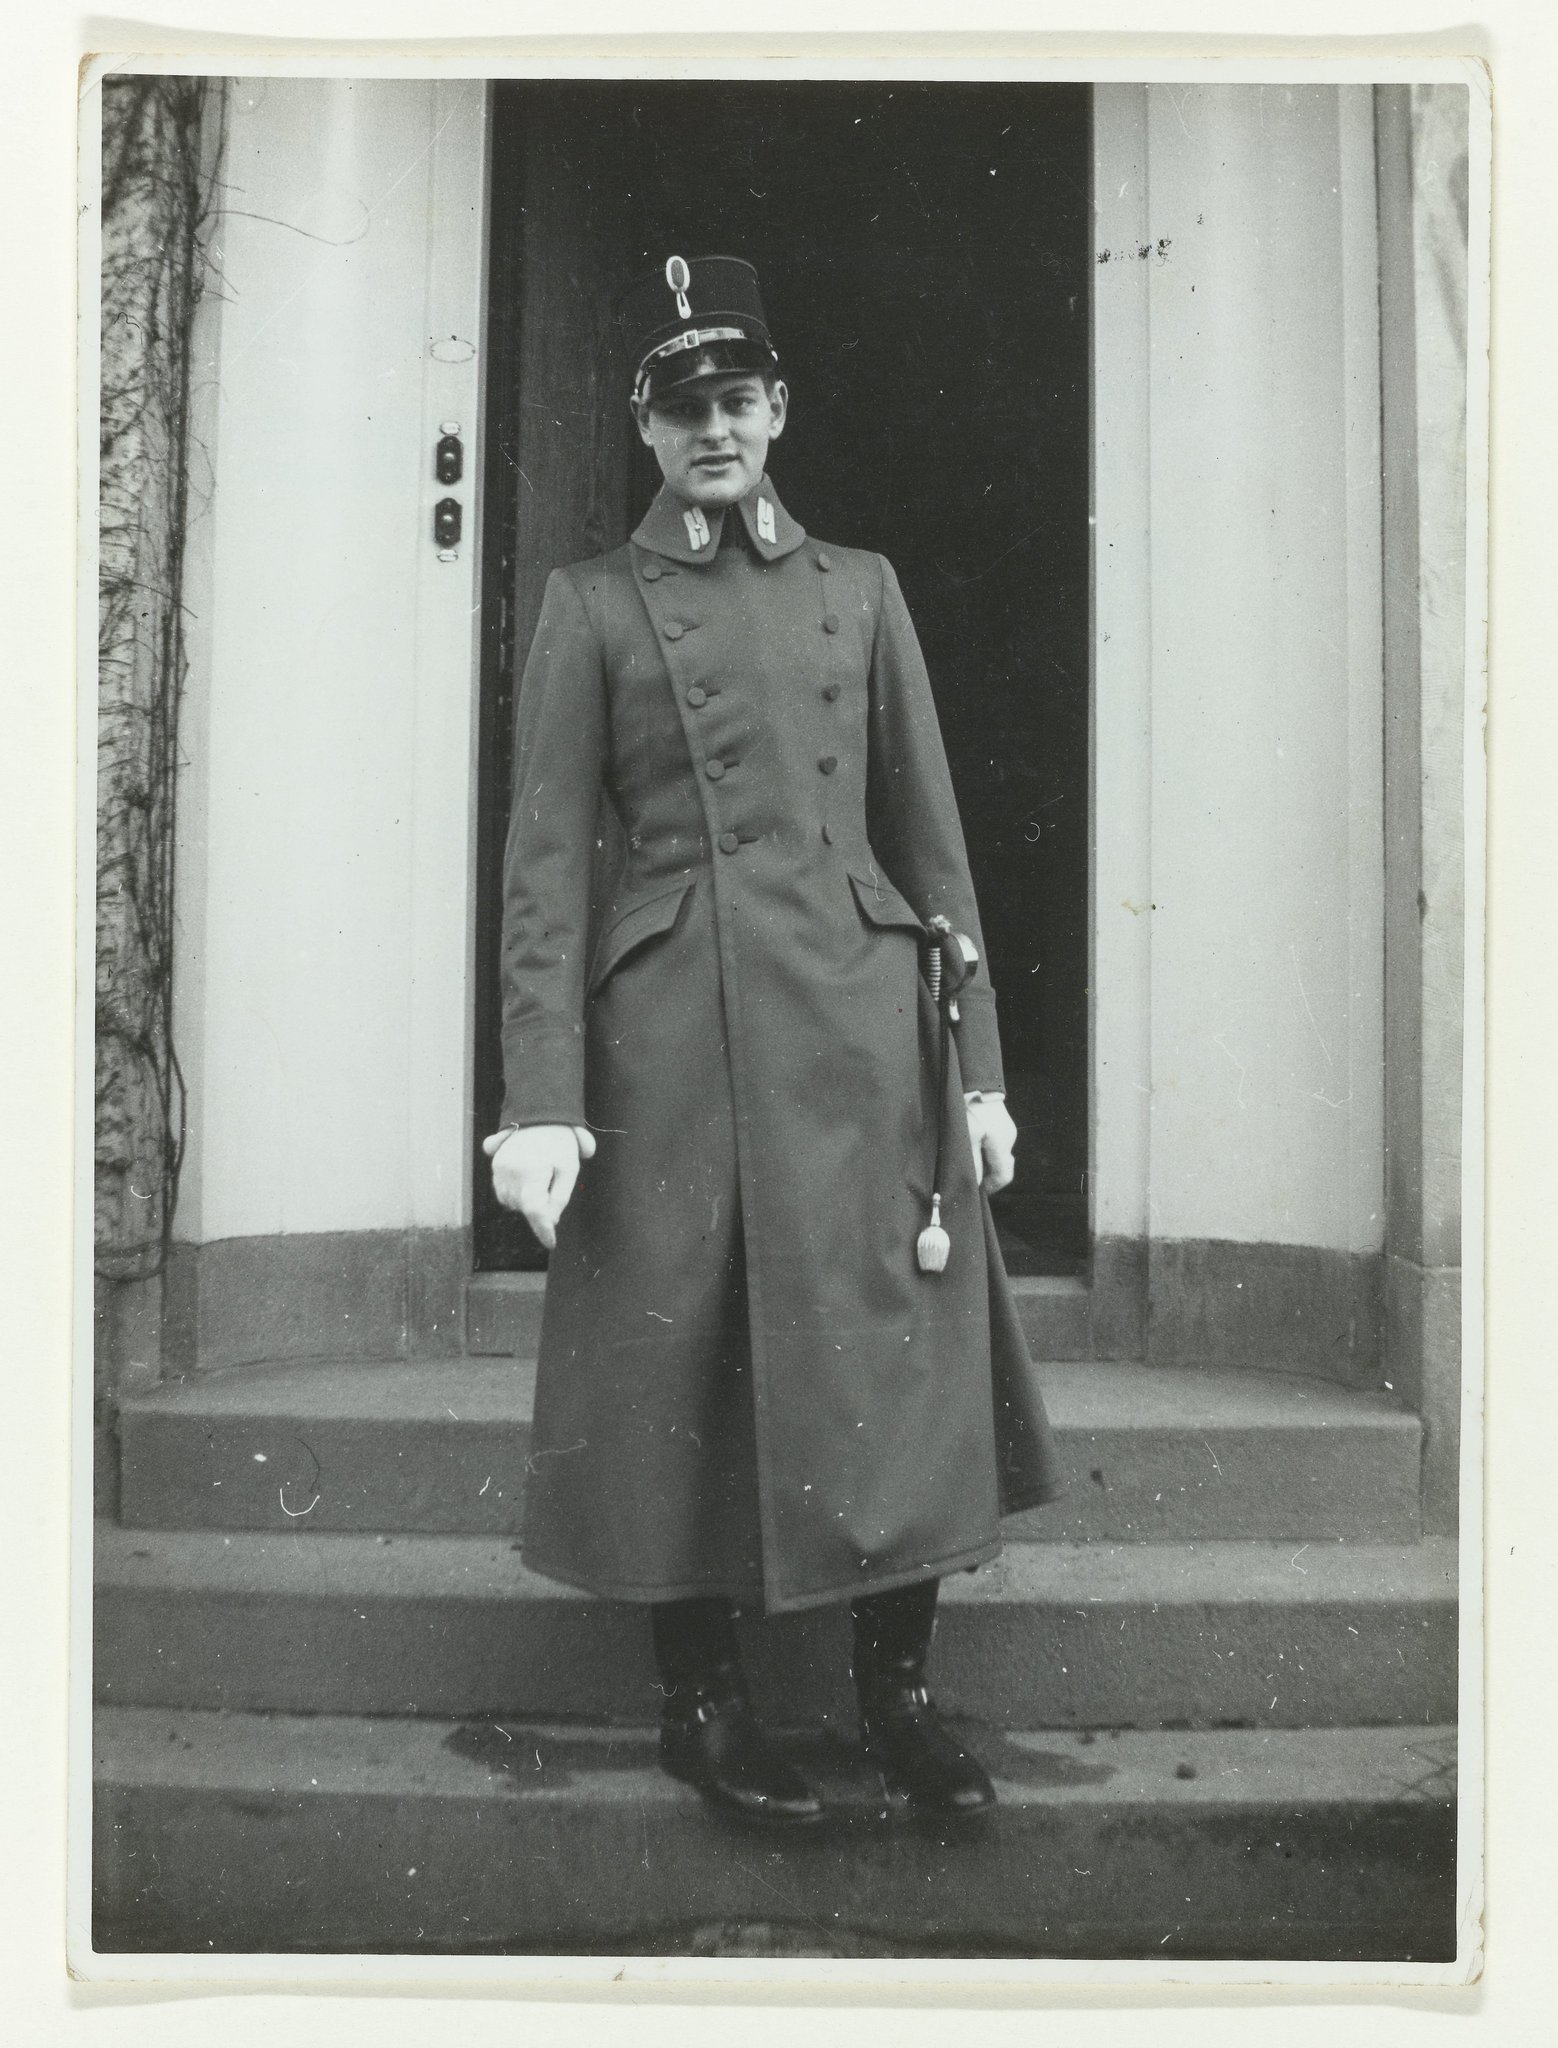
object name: photograph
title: Tonny van Renterghem als cornet 1e regiment huzaren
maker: Anonymous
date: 1938-1939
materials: photographic support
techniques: photography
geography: amsterdam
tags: amsterdam, tonny van renterghem, netherlands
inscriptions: inscription: ‘originele foto. cornet (=vaandrig) 1e Regiment Huzaren laatste jaar van de cavalerie te paard . klein tenue - overjas - kleur = hemelsblauw 1938/39. Tonny van Renterghem.’, inscription: ‘'De Amateur' P.C. Hoofdstr. .. Amsterdam’, monogram: ‘TvR’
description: Foto van Tonny van Renterghem in klein tenue met overjas en sabel, staande op een stoep.